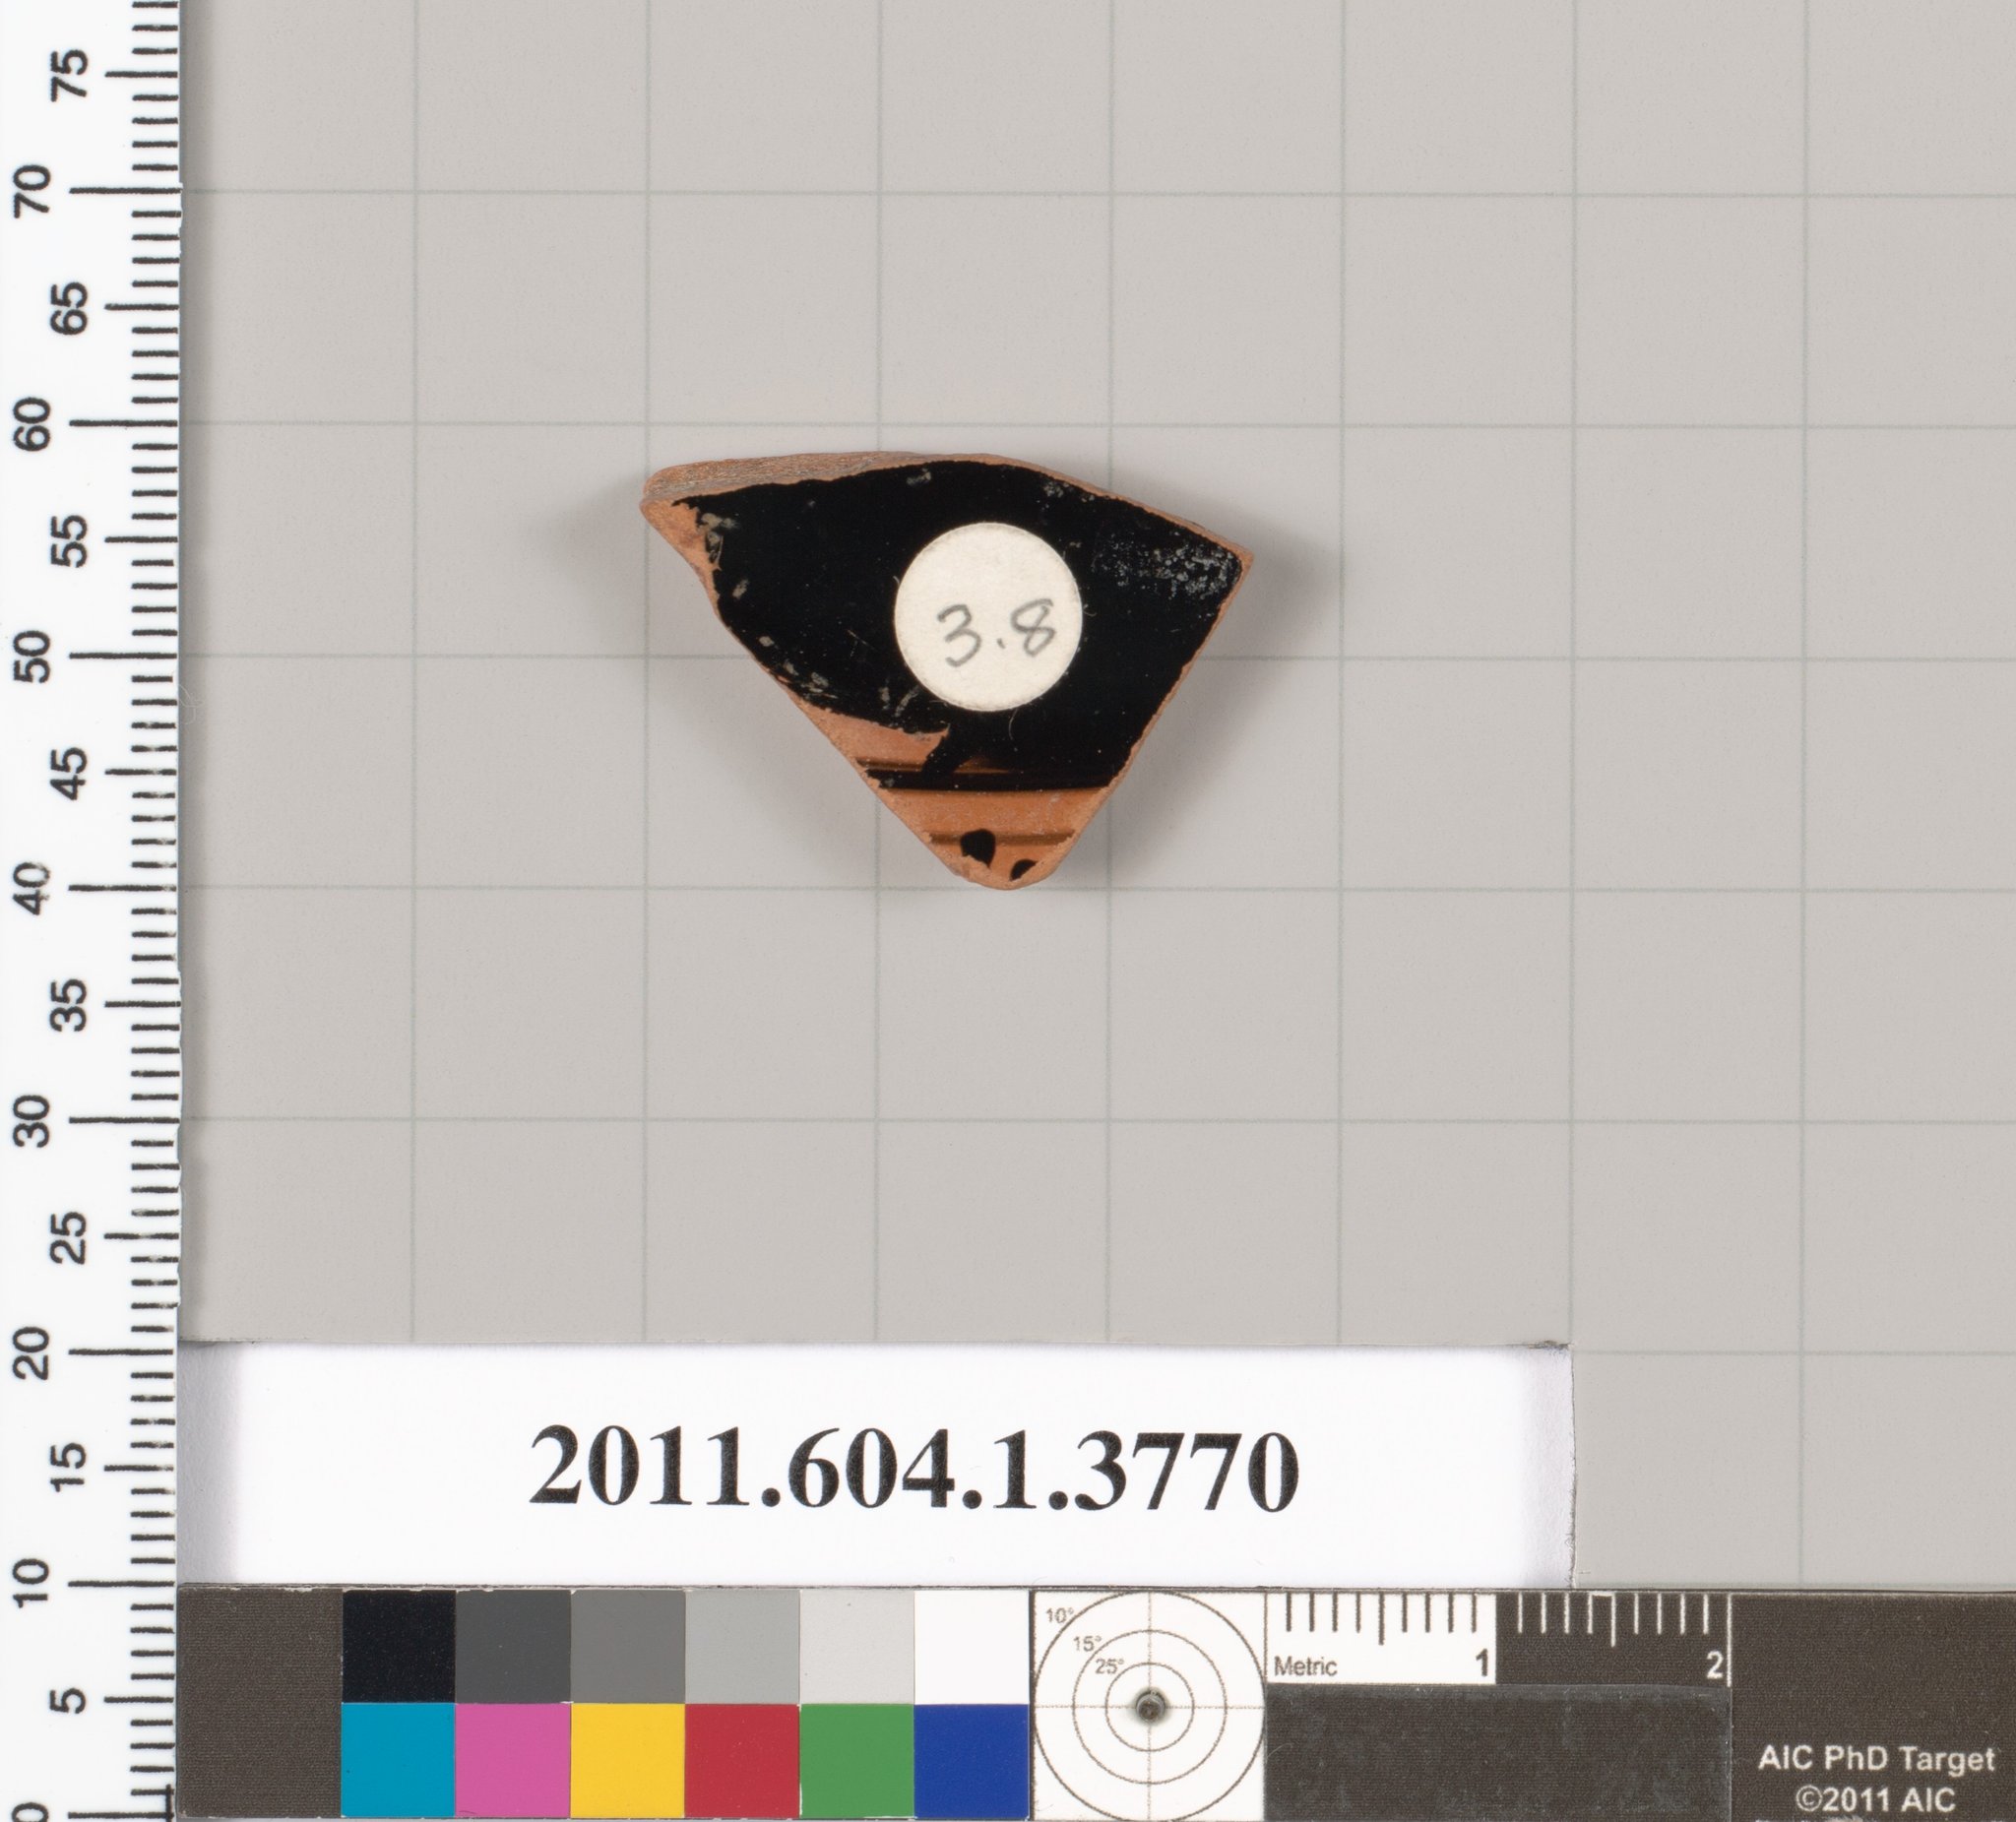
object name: kylix fragment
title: Terracotta fragment of a kylix (drinking cup)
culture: greek, attic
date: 401-450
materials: terracotta